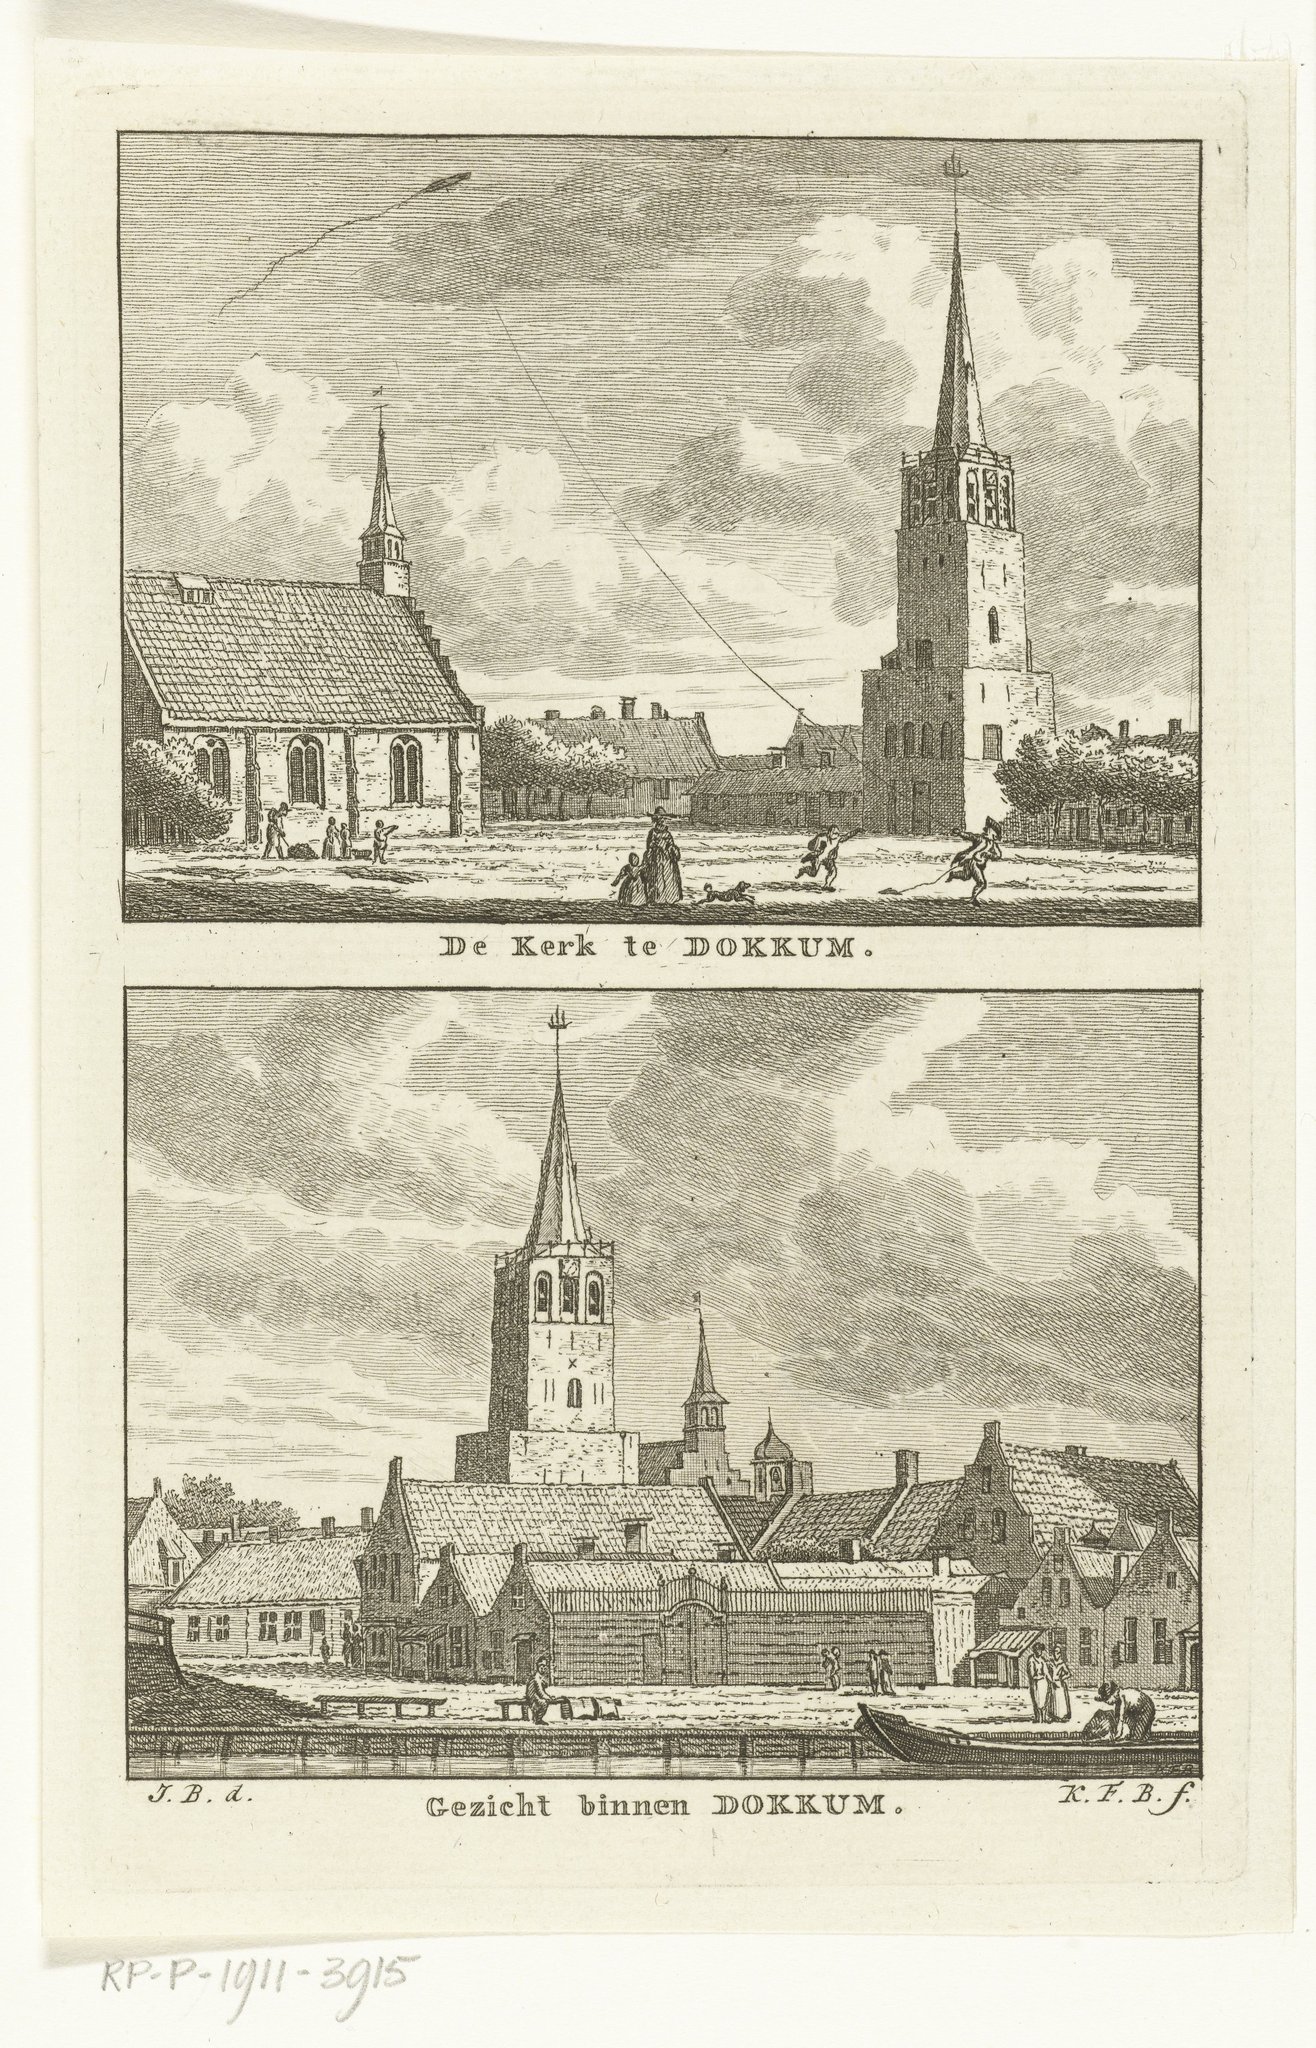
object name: print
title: Twee dorpsgezichten met kerk en kerktoren te Dokkum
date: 1786-1792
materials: paper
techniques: etching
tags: village, church (exterior)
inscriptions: collector's mark: Lugt 2228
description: Prent uit: Vaderlandsche gezichten, of afbeeldingen van den tegenwoordigen staat der Vereenigde Nederlanden (…). Amsterdam: Hendrik Gartman, Willem Vermandel en Jan Willem Smit, 1786-1792. Uitgegeven in afleveringen met ieder een eigen bifolium en inhoudsopgave. Alle prenten in deze publicatie zijn gegraveerd door Carel Frederik Bendorp (I) en, in de meeste gevallen, gebaseerd op tekeningen van Jan Bulthuis.